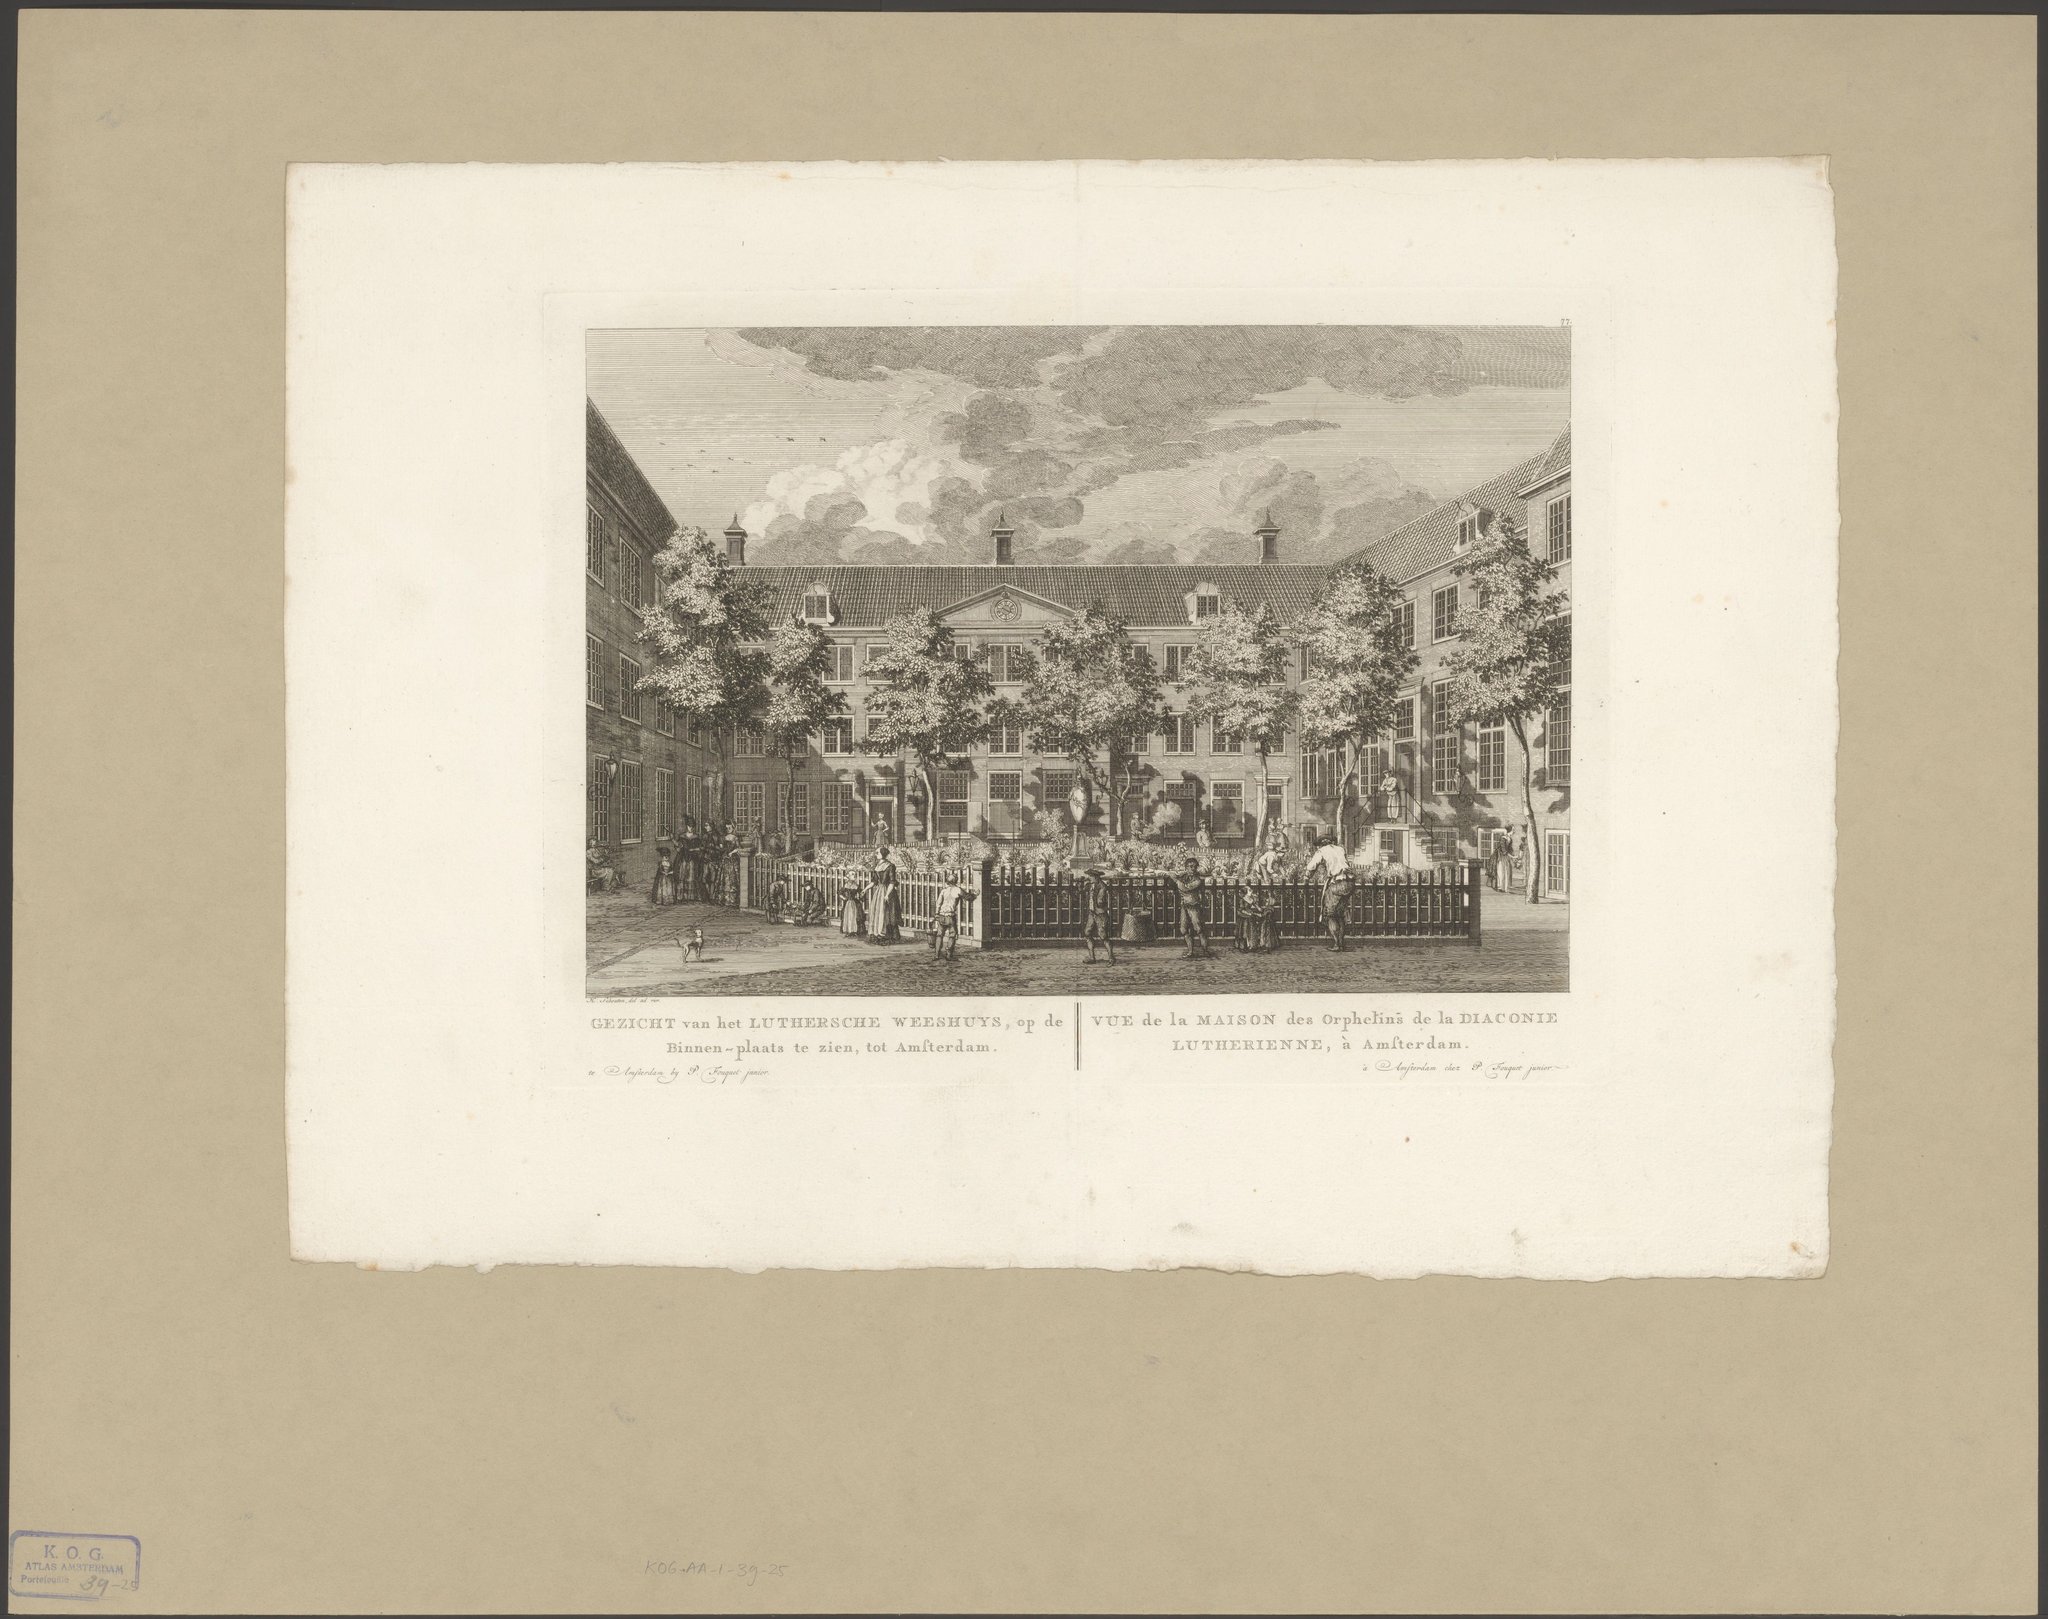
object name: print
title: Gezicht op de binnenplaats van het Lutherse Diaconieweeshuis te Amsterdam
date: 1770-1783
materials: paper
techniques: engraving, etching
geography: amsterdam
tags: courtyard, orphanage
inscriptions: collector's mark: Lugt 1641b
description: Vanaf 1760 gaf Pierre Fouquet stadsgezichten van Amsterdam naar tekeningen van verschillende kunstenaars uit. Deze prenten werden aanvankelijk los verkocht. Later werden ze samengebonden verkocht in verschillende volgordes en aantallen in: (1). Afbeeldingen van de wyd-vermaarde koopstad Amsterdam benevens des zelvs voornaamste gebouwen en gezigten alle naar het leeven getekend / Receuil des edifices les plus considerables et des plus belles vues, de la fameuse ville d'Amsterdam, dessinées d'après nature. Amsterdam: Pierre Fouquet, 1778-1783. Deze 'uitgave' bestond waarschijnlijk alleen uit een titelblad en inhoudsopgave van de tot dusver 100 uitgegeven prenten, die de koper zelf aan zijn of haar reeds verzamelde prenten kon toevoegen. De hoeveelheid en volgorde van prenten verzameld onder deze titel verschilt dus sterk. (2). Nieuwe atlas, van de voornaamste gebouwen en gezigten der stad Amsterdam, met derzelver beknopte beschryvingen. 2 dln. Amsterdam: Daniël Jean Changuion en Petrus den Hengst [in opdracht van Pierre Fouquet], 1783. Ook werden er door verschillende uitgevers tussen 1788 (Amsterdam: Petrus Conradi) en 1805 (Amsterdam: Evert Maaskamp) heruitgaven gepubliceerd.